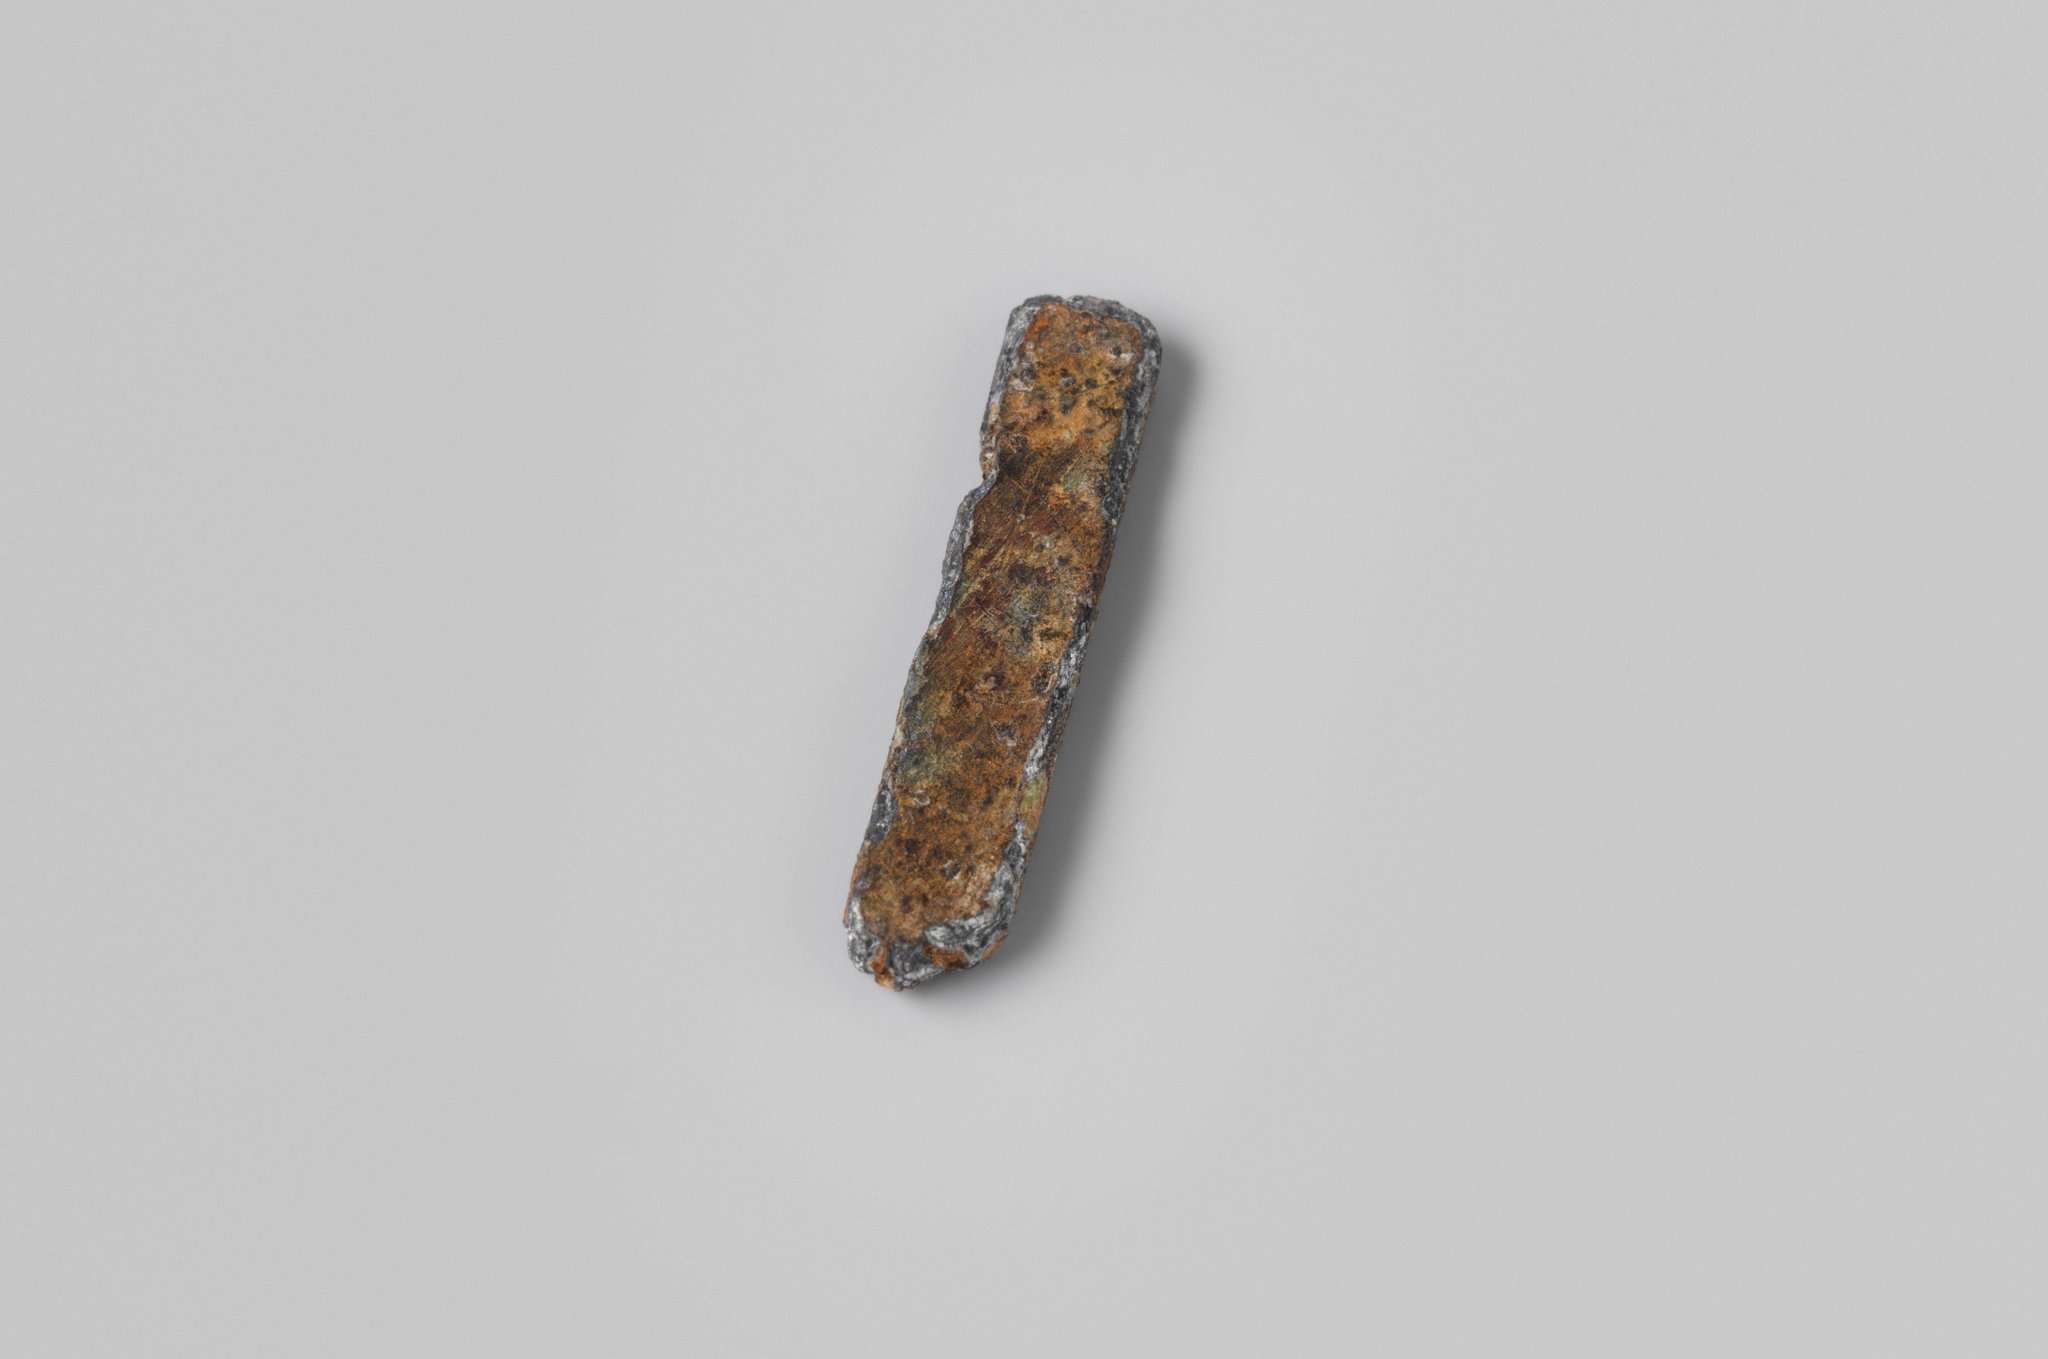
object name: type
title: Drukletter uit het wrak van de Oost-Indiëvaarder Hollandia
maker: Anonymous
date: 1700-1743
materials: lead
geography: netherlands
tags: verenigde oostindische compagnie, hollandia (schip), annet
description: Printing type; rectangular, eroded, groove in one side, characters illegible.